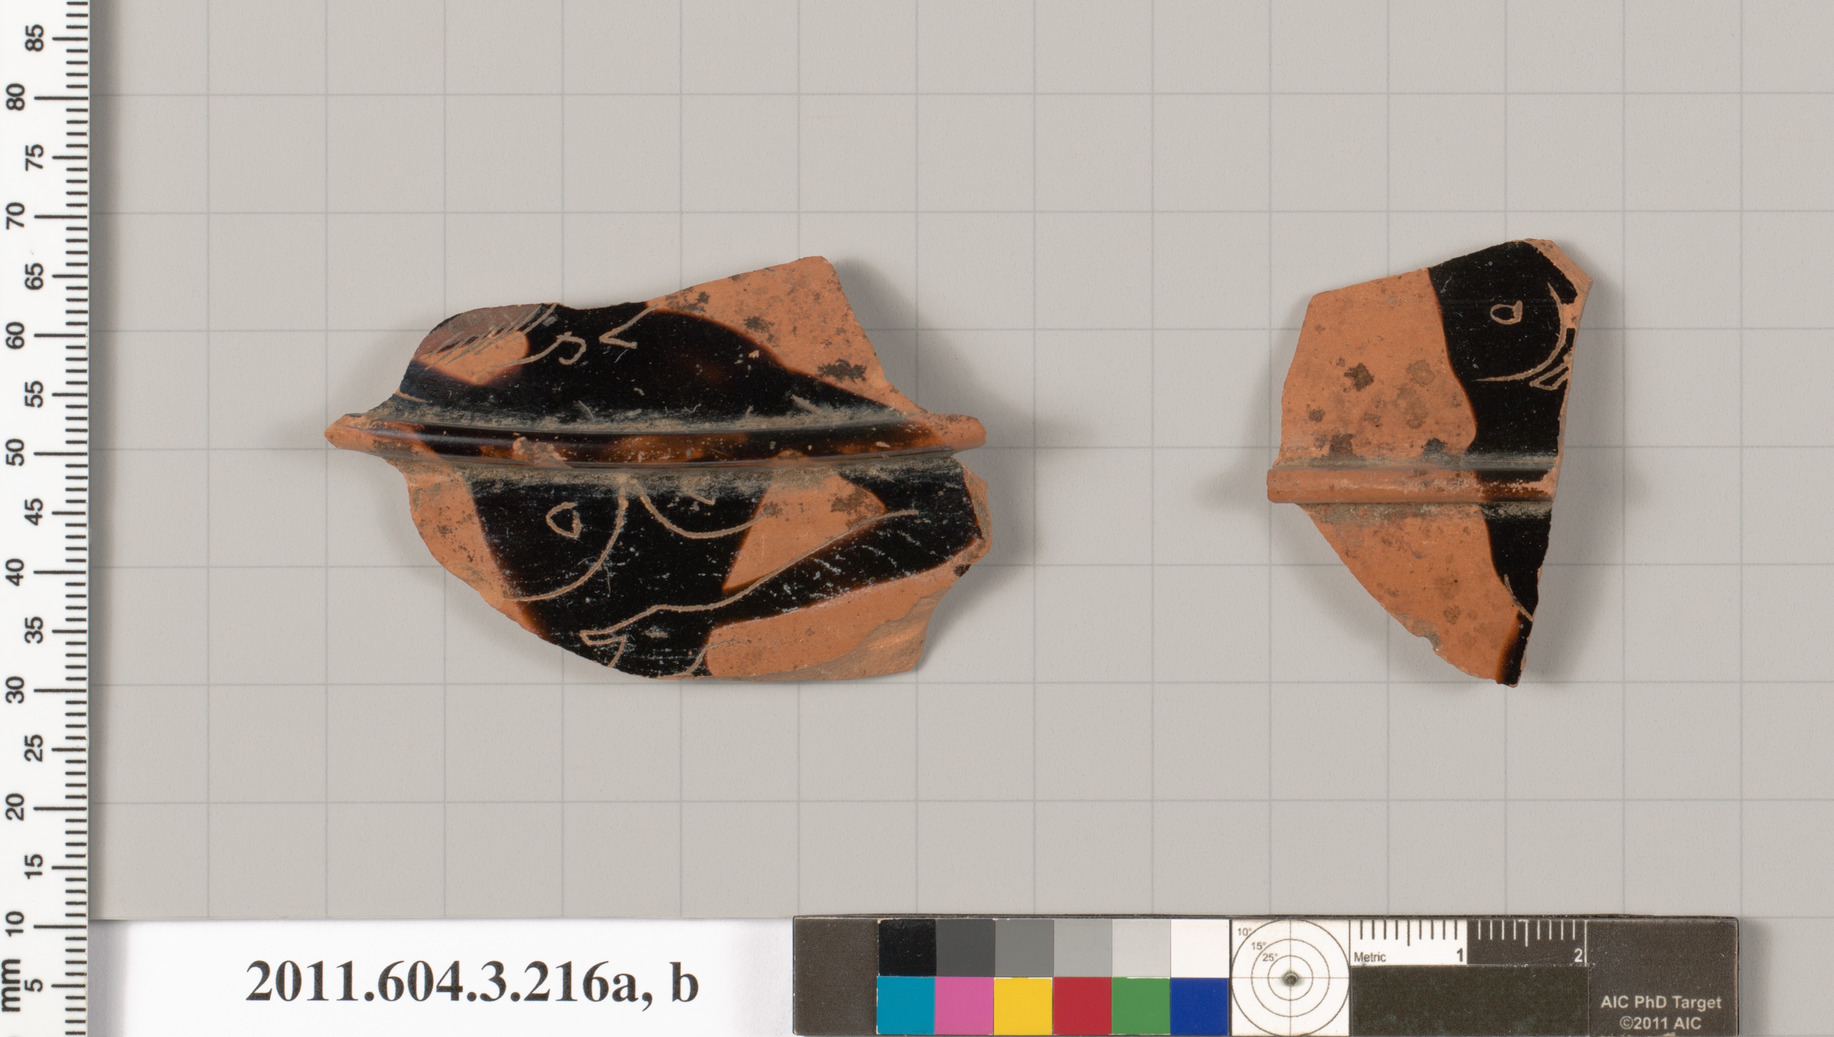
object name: neck amphora fragment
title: Terracotta fragments of a neck-amphora of Nicosthenic shape (jar)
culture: greek, attic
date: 525-501 BCE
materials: terracotta